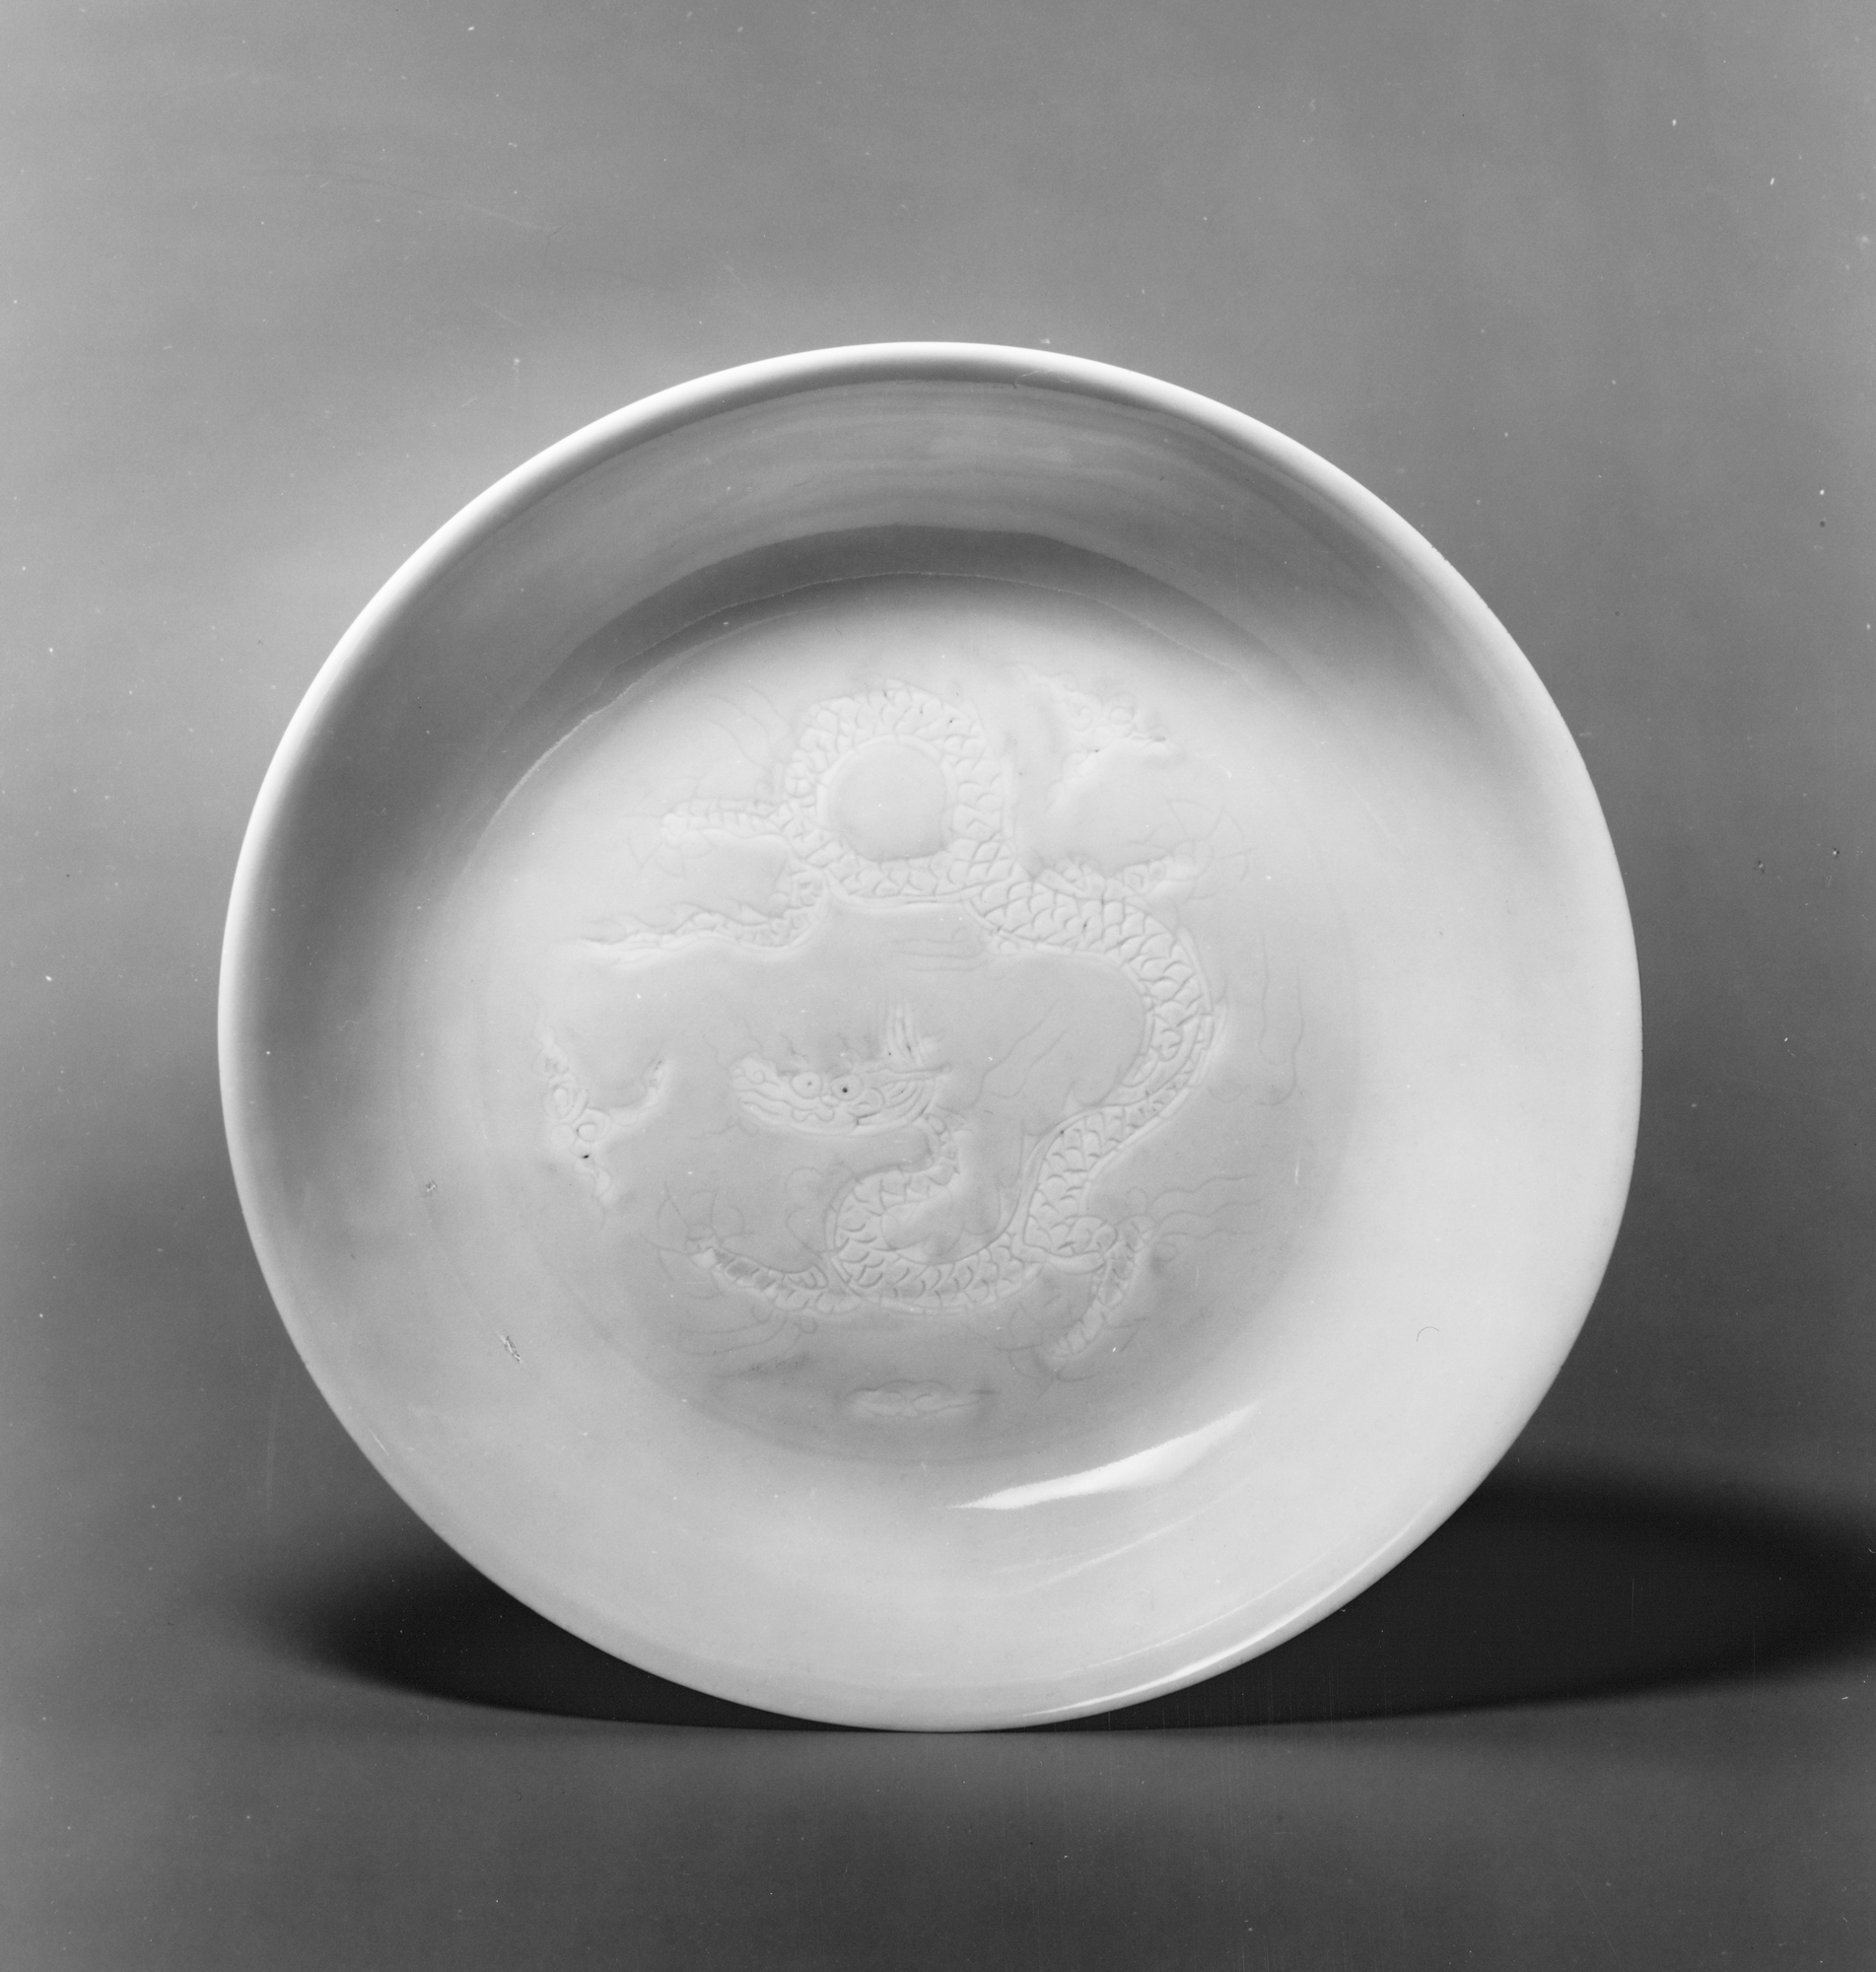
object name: dish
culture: chinese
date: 1488-1505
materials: biscuit, porcelain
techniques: incising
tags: dragons